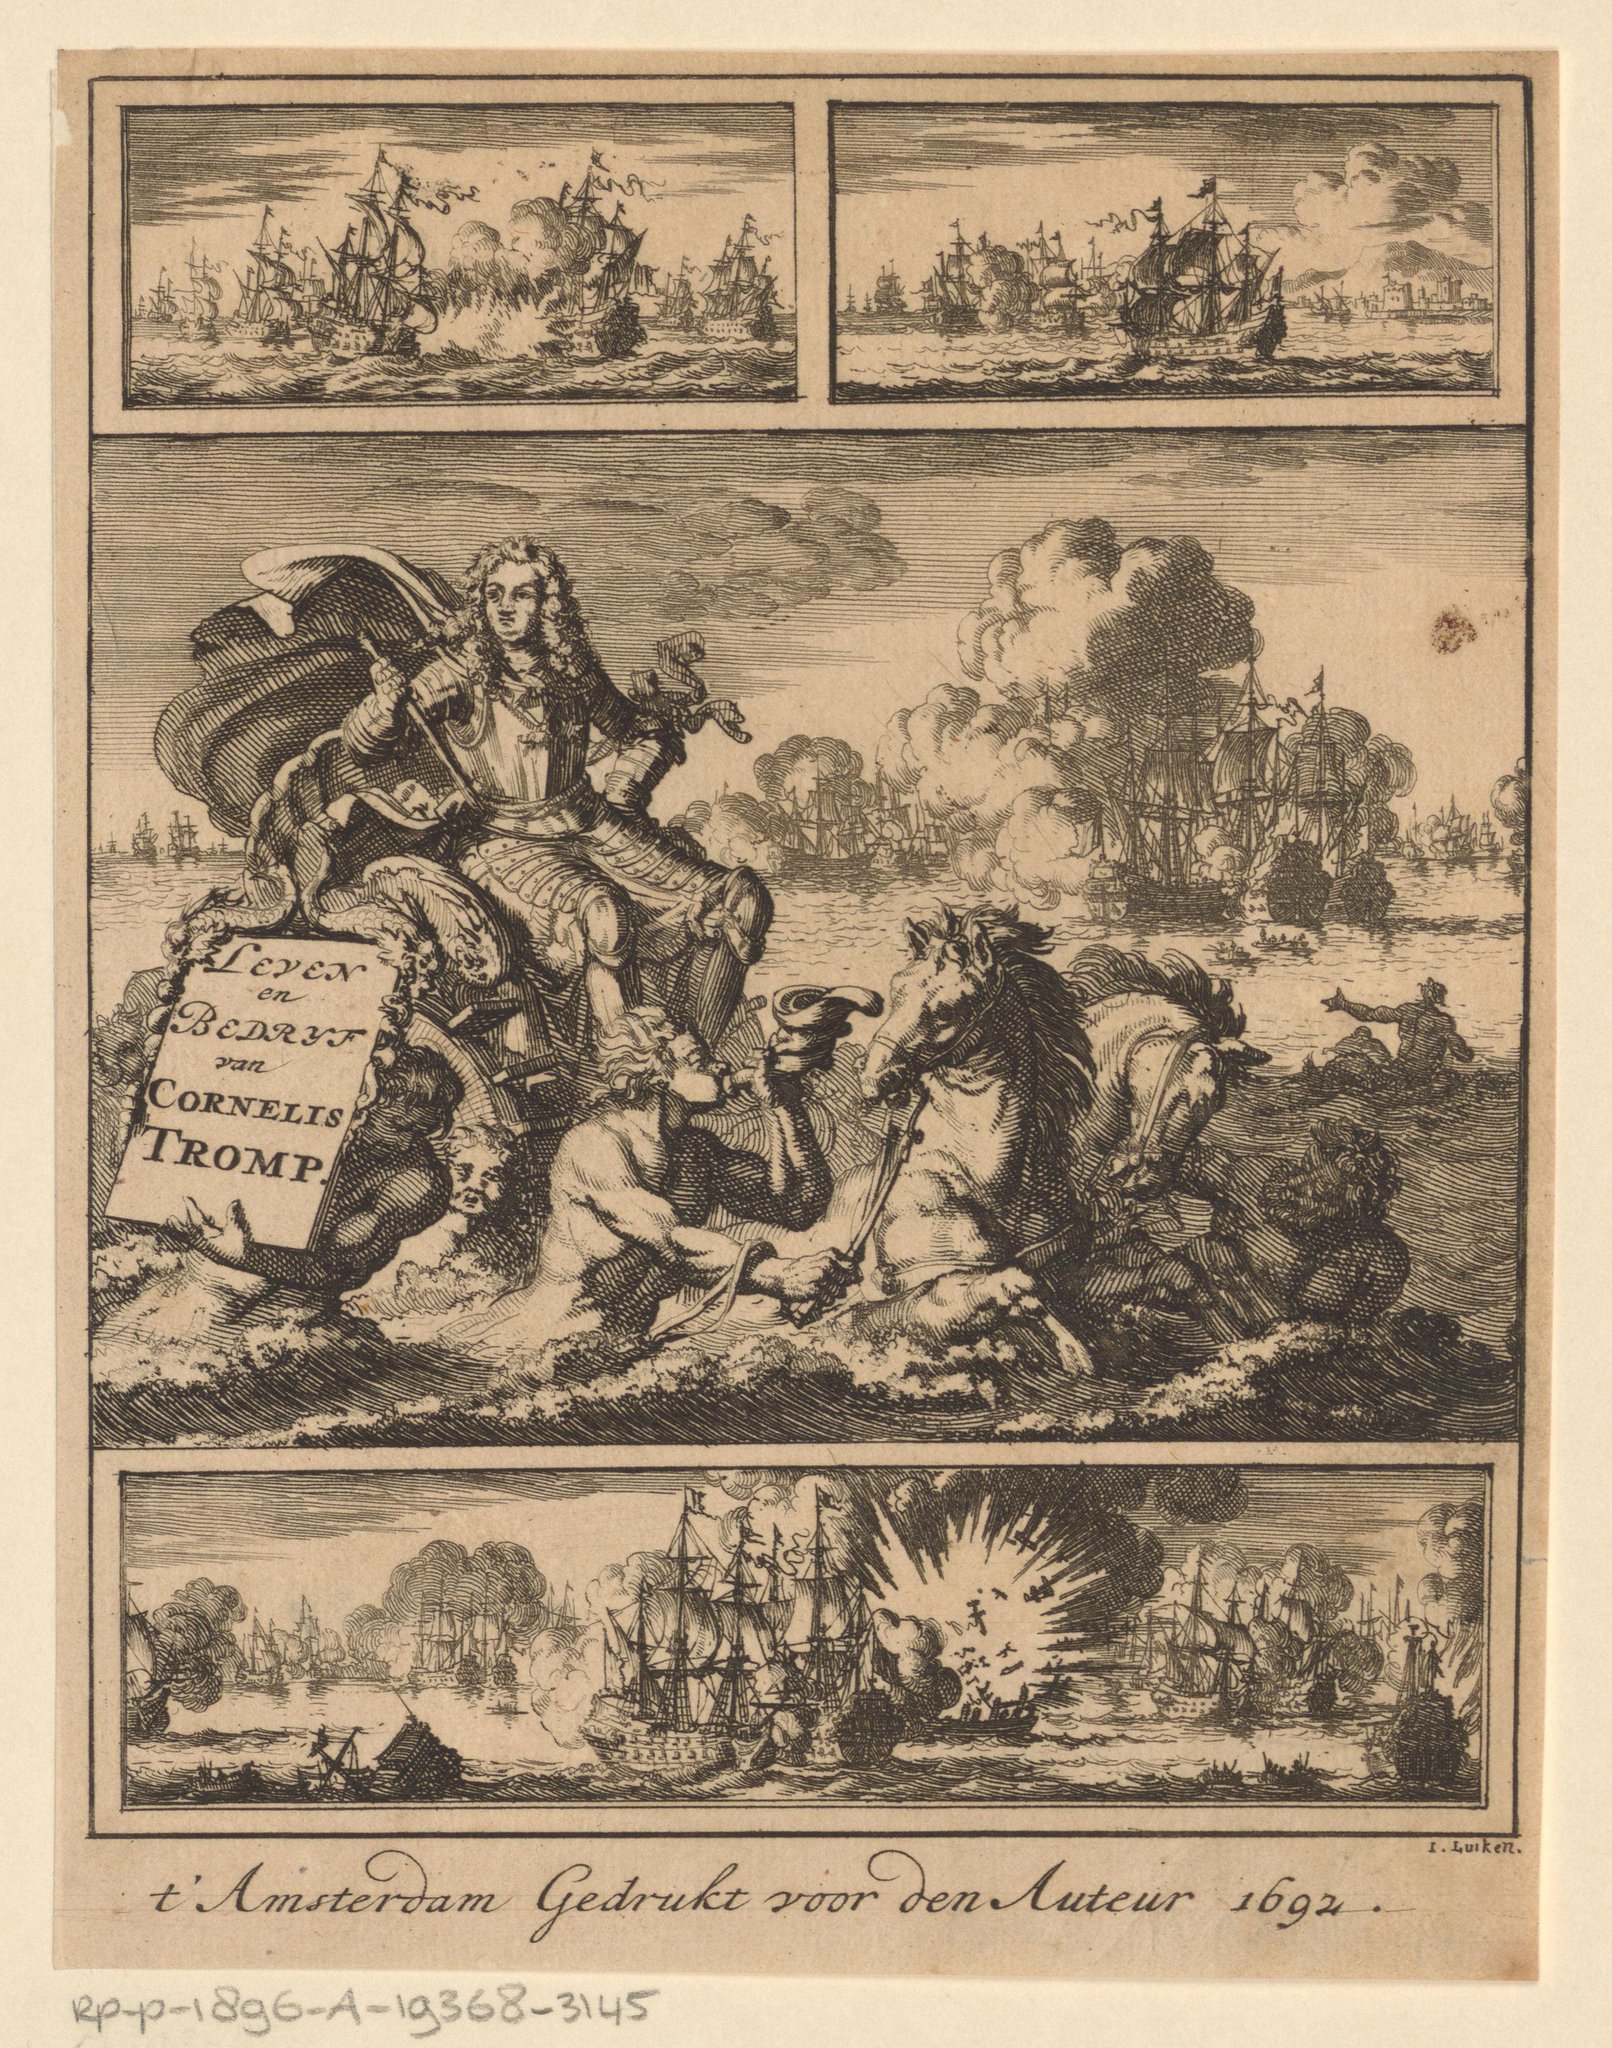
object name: print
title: Cornelis Tromp op een zegekar voortgetrokken door zeepaarden en begeleid door tritons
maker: jan luyken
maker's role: draughtsman, print maker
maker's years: 1649-1712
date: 1692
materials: paper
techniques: etching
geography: amsterdam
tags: rotterdam, amsterdam, cornelis tromp, triton(s), sea-horse, hippocamp, 'hippocampus', (horse/fish) (mythological hybrid monster), armour, battle (+ naval force), chariot, triumphal car, historical persons, military glory, commander-in-chief, admiral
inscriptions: collector's mark: Lugt 2228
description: Prent waarschijnlijk uit: Leven en bedryf van den vermaarden zeeheld Cornelis Tromp. Amsterdam: Timotheus ten Hoorn; Haarlem: Jacob Albertsz van Beverwĳk, 1692.